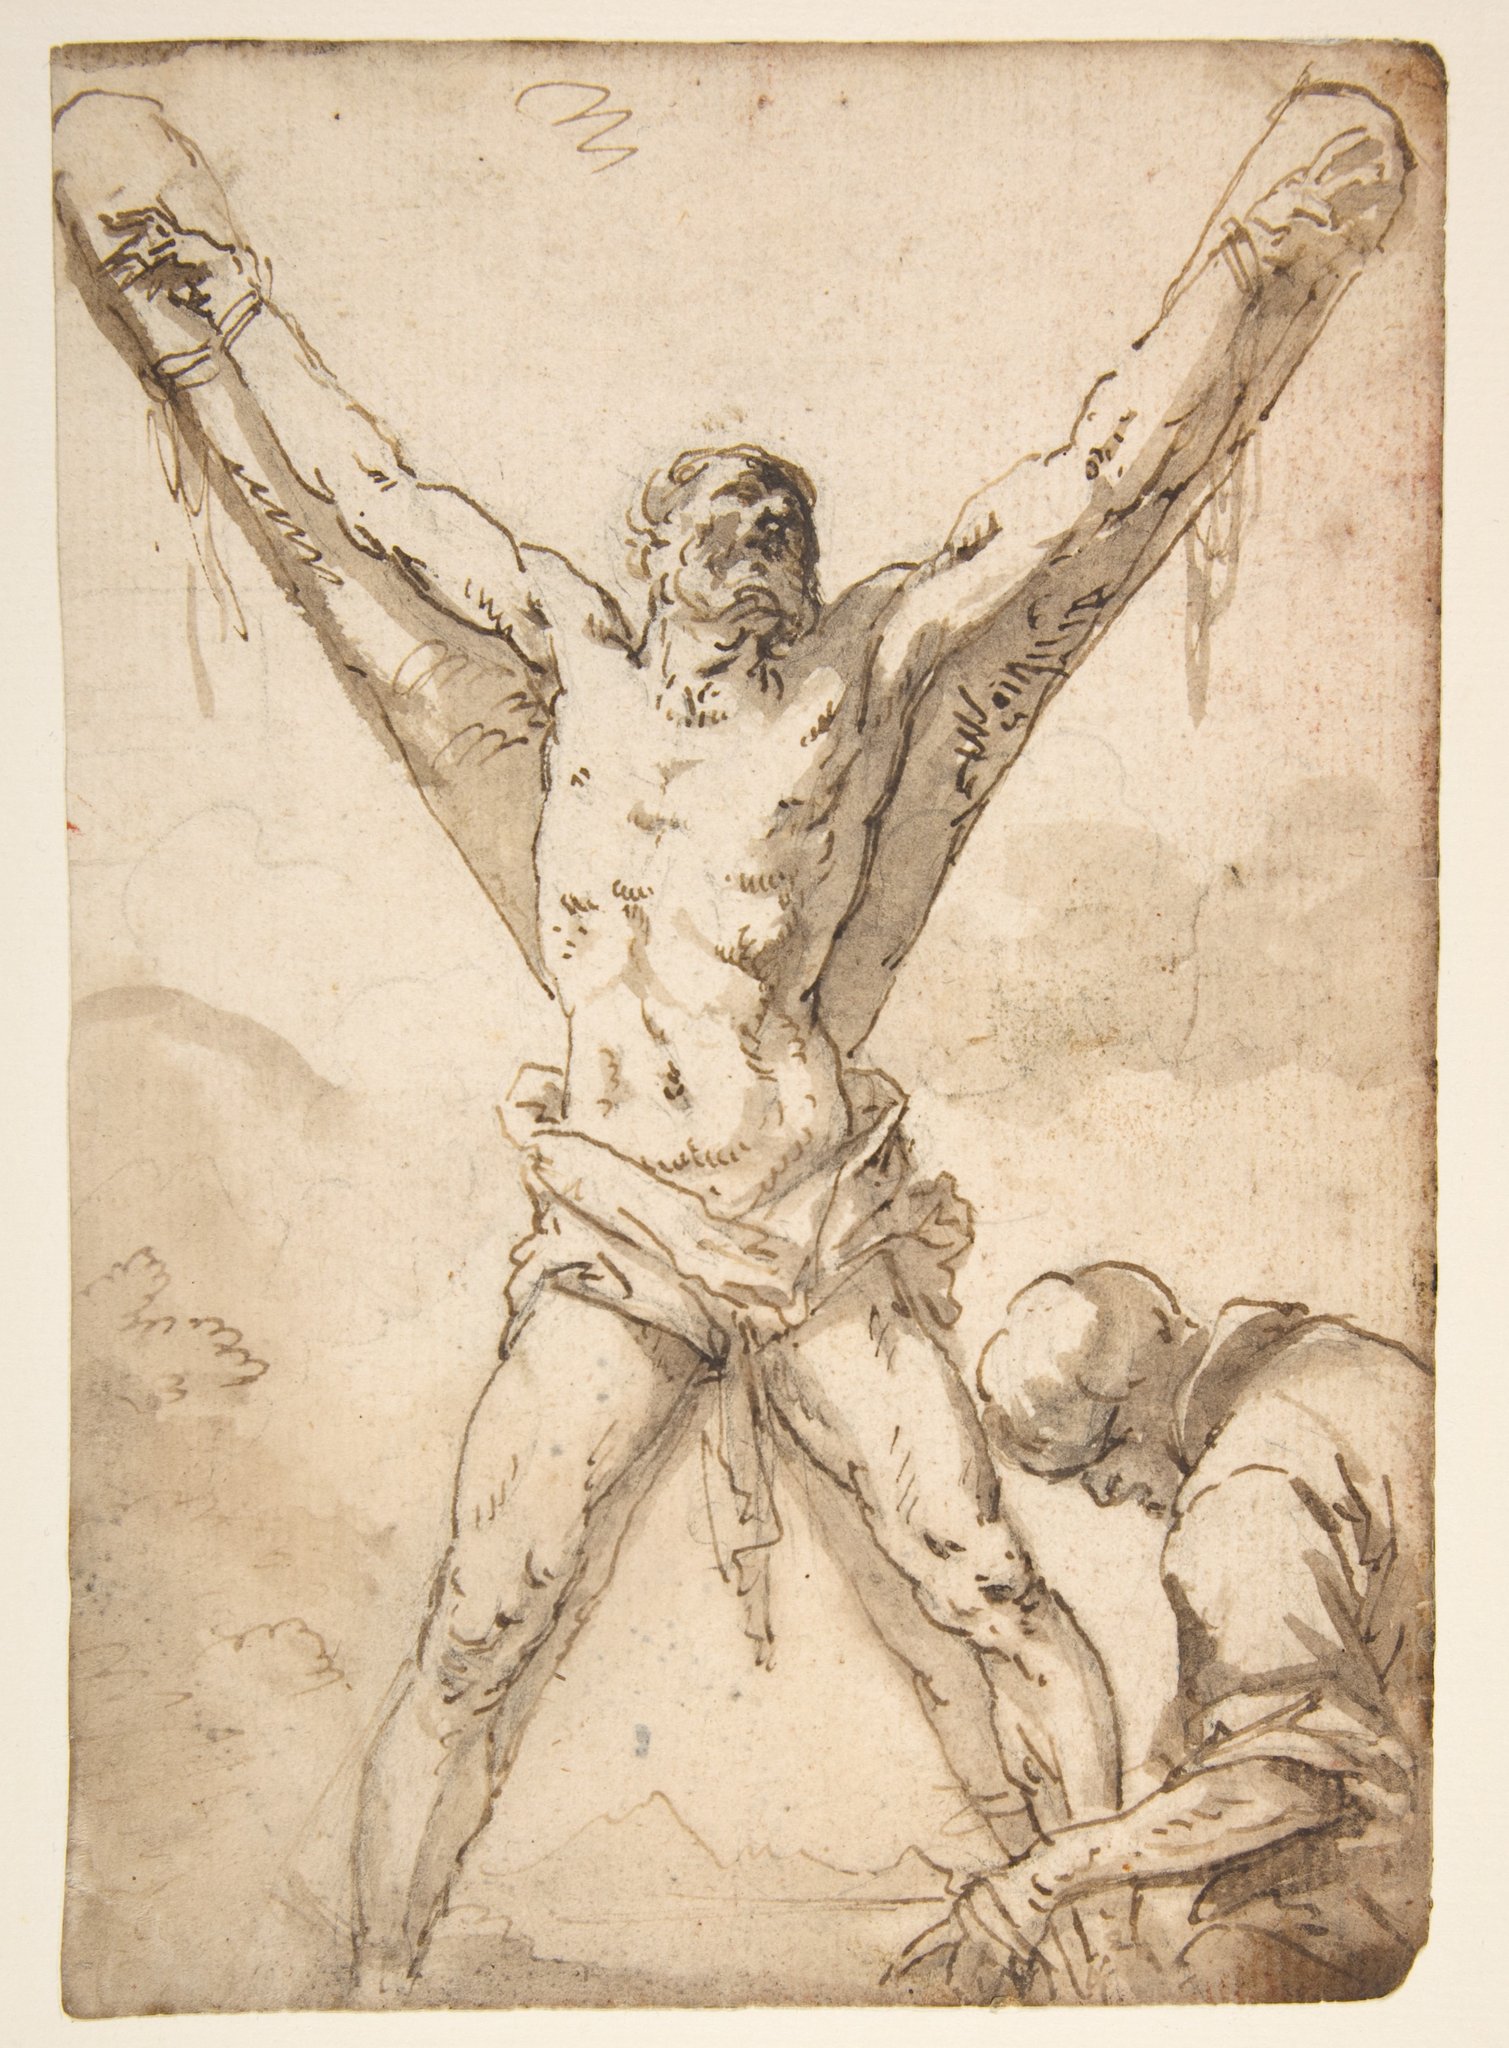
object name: drawing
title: Martyrdom of St. Andrew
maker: salvator rosa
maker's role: artist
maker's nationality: italian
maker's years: 1615-1673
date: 1615-1673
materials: chalk, ink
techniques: pen, wash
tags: men,saints